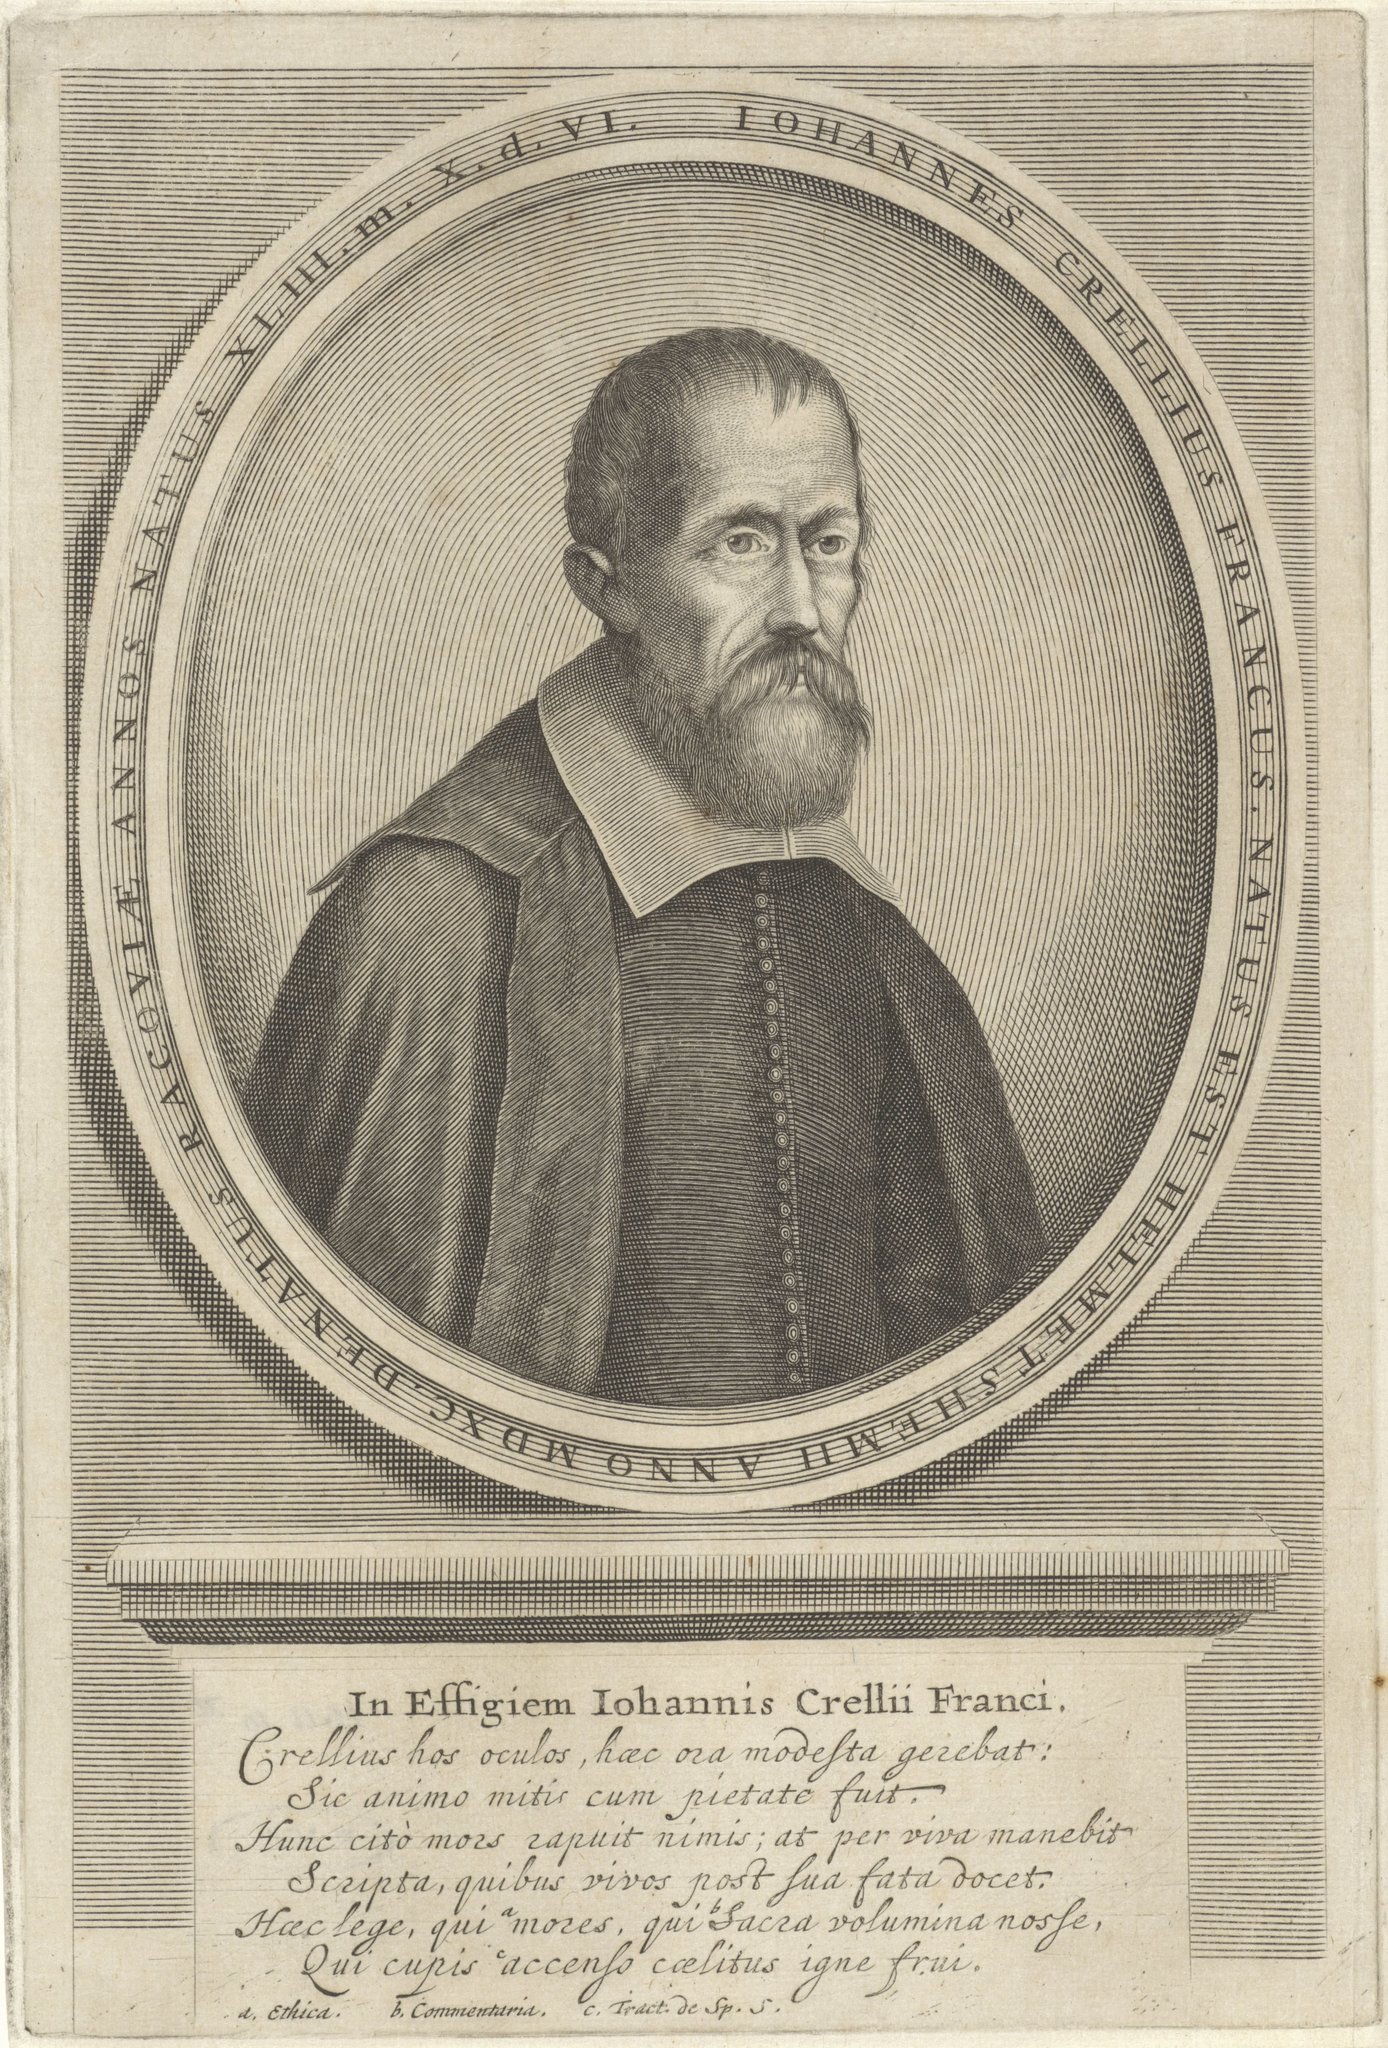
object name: print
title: Portret van Johannes Crellius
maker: lambert visscher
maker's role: draughtsman, print maker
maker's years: 1640-1679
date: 1643-1691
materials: paper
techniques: engraving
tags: beard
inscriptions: collector's mark: Lugt 2228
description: Johannes Crellius op 43-jarige leeftijd. Hij draagt een korte baard en snor en is gekleed in een toga. Op de stenen sokkel waarop het portret rust zijn naam en een lofdicht in Latijn.